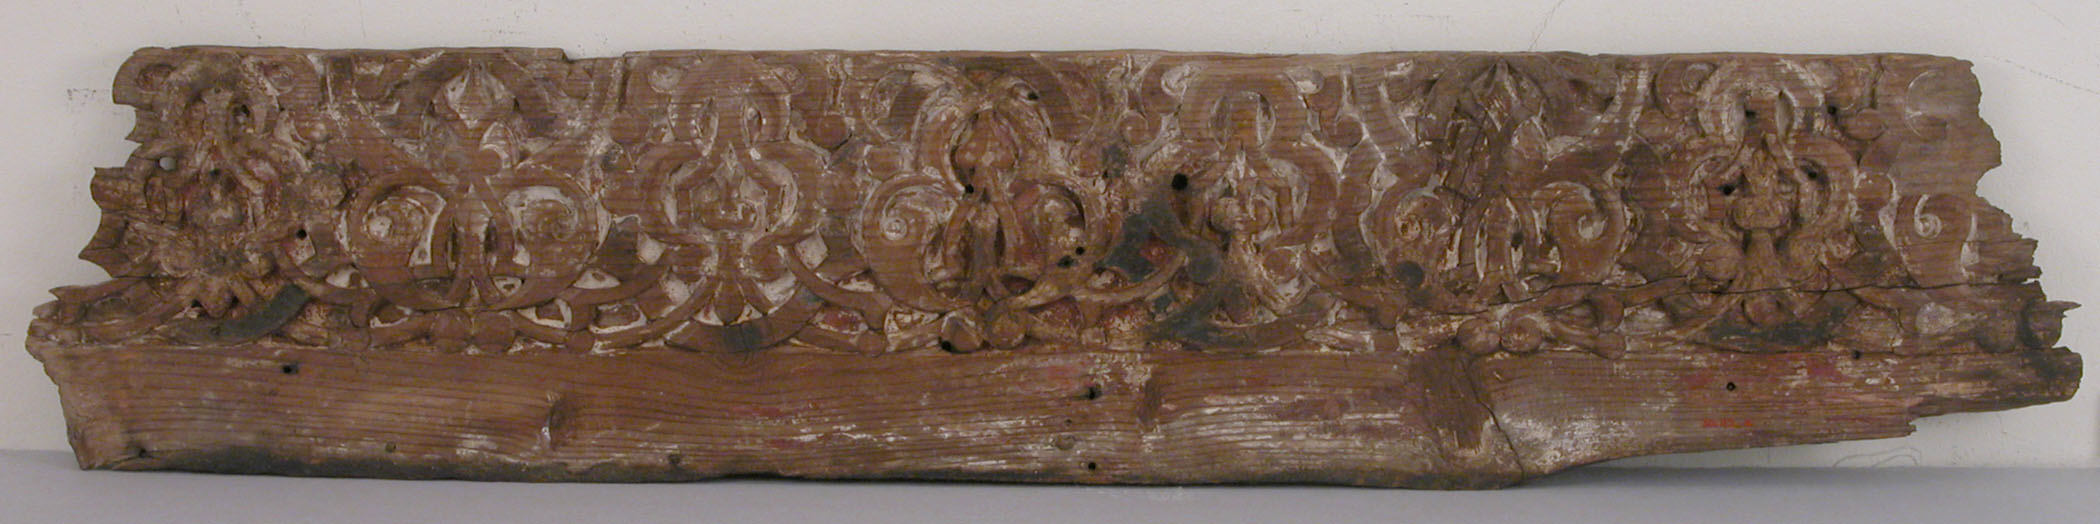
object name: panel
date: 1201-1500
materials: wood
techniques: carving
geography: egypt